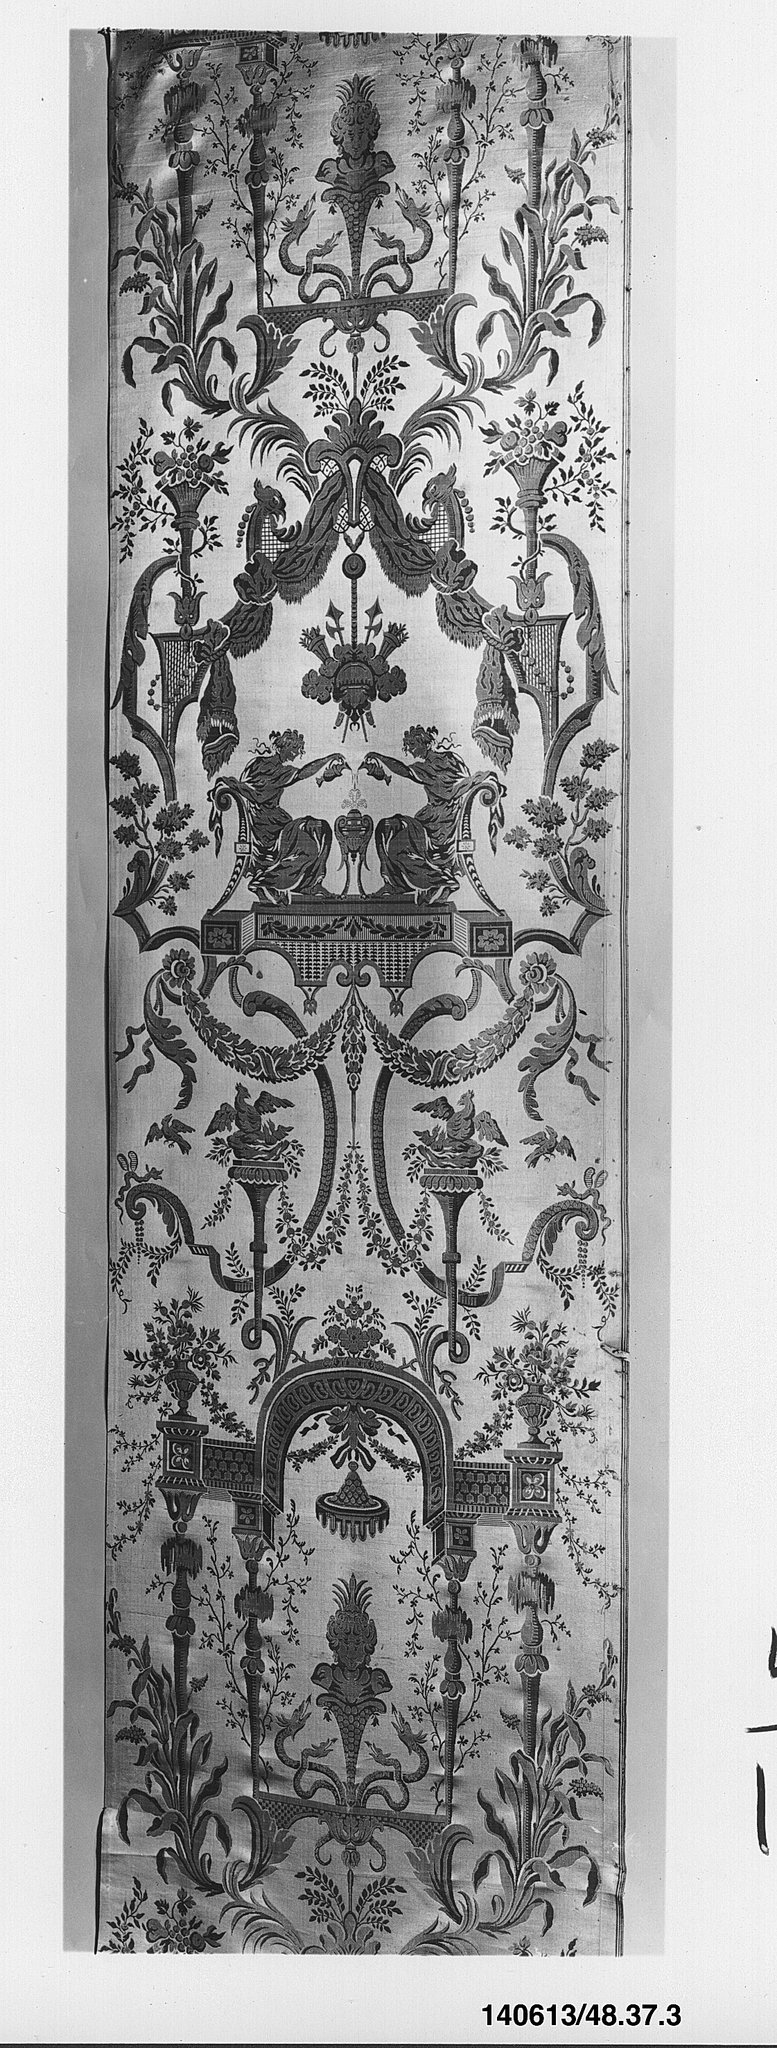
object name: panel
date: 1780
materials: silk